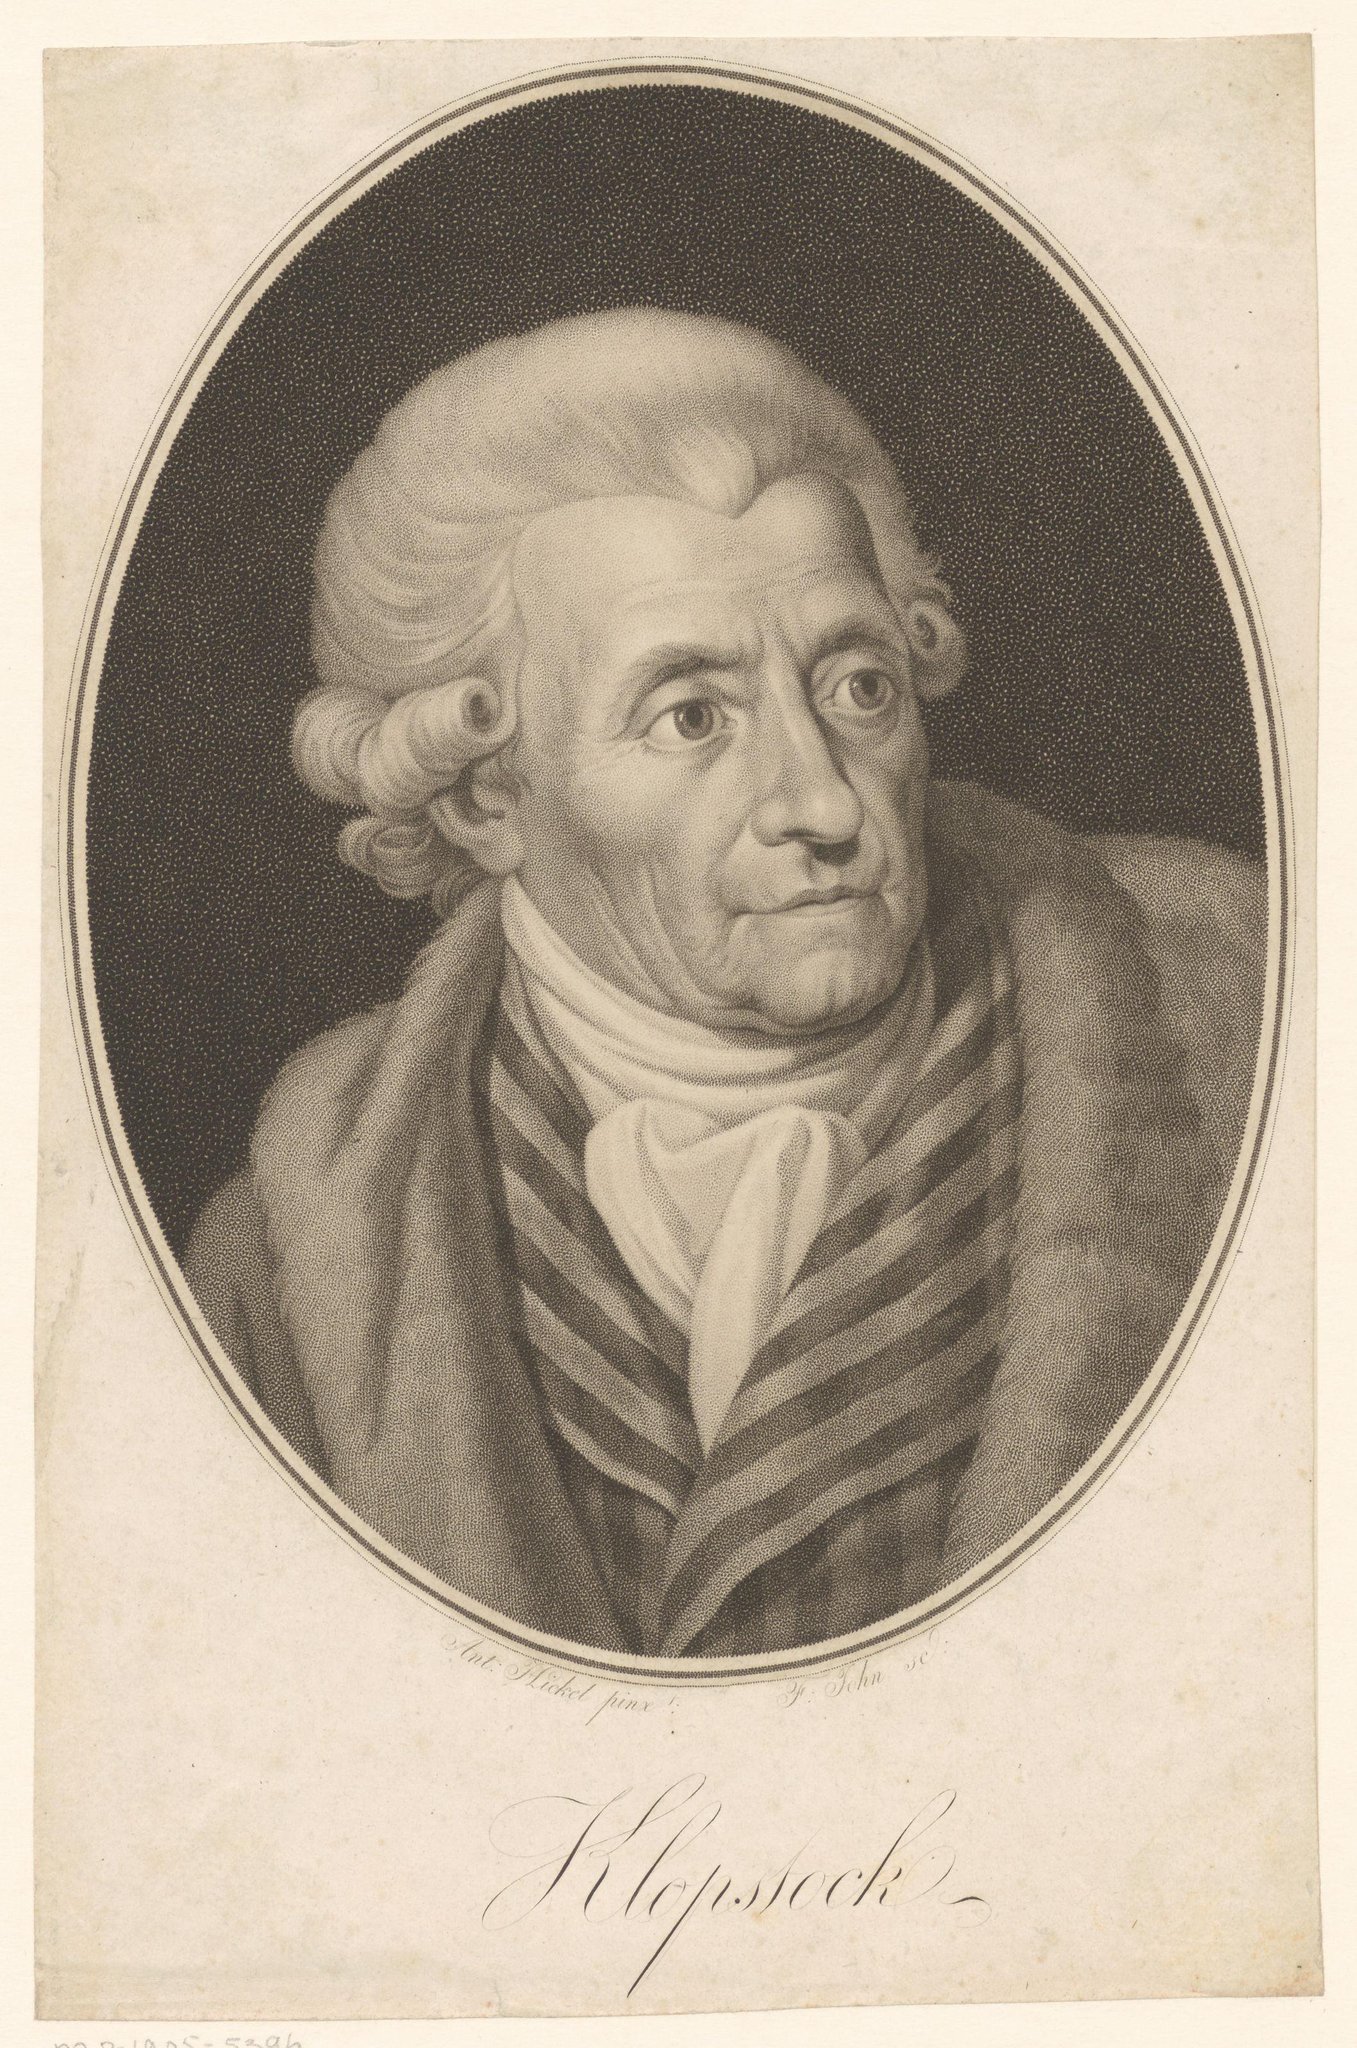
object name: print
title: Portret van Friedrich Klopstock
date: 1789-1843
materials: paper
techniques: stippling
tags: historical persons, writer, poet, author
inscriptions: collector's mark: Lugt 2228